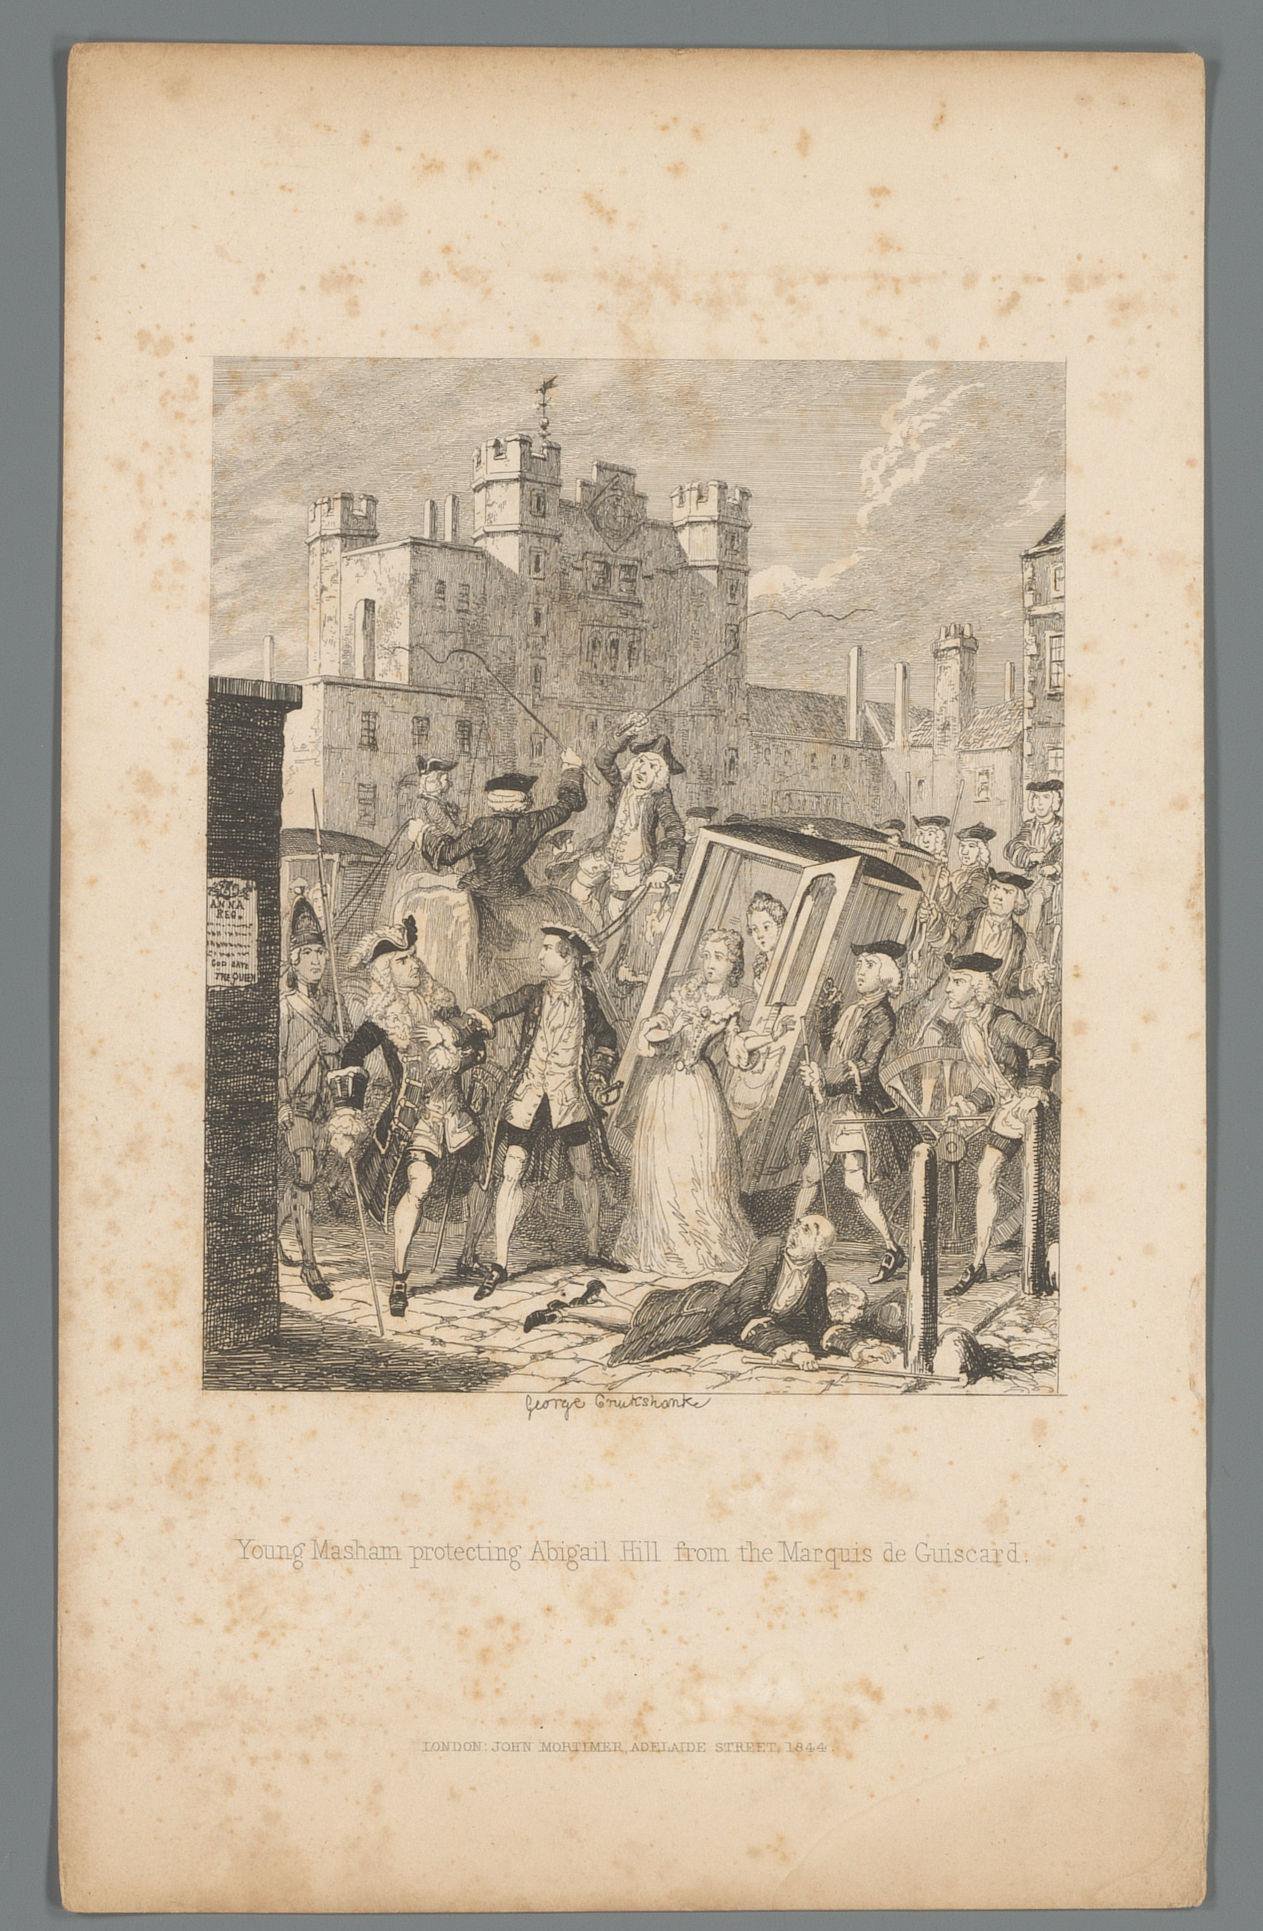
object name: print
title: Masham beschermt Abigail Hill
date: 1844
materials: paper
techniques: etching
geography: england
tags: (carrying a person in a) sedan-chair, fighting, political caricatures and satires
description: Samuel Masham beschermt Abigail Hill tegen de boze markies de Guiscard, na een botsing tussen haar draagstoel en de koets van de markies. Illustratie voor een uitgave van "St James's, or the Court of Queen Anne" van Ainsworth, 1844.